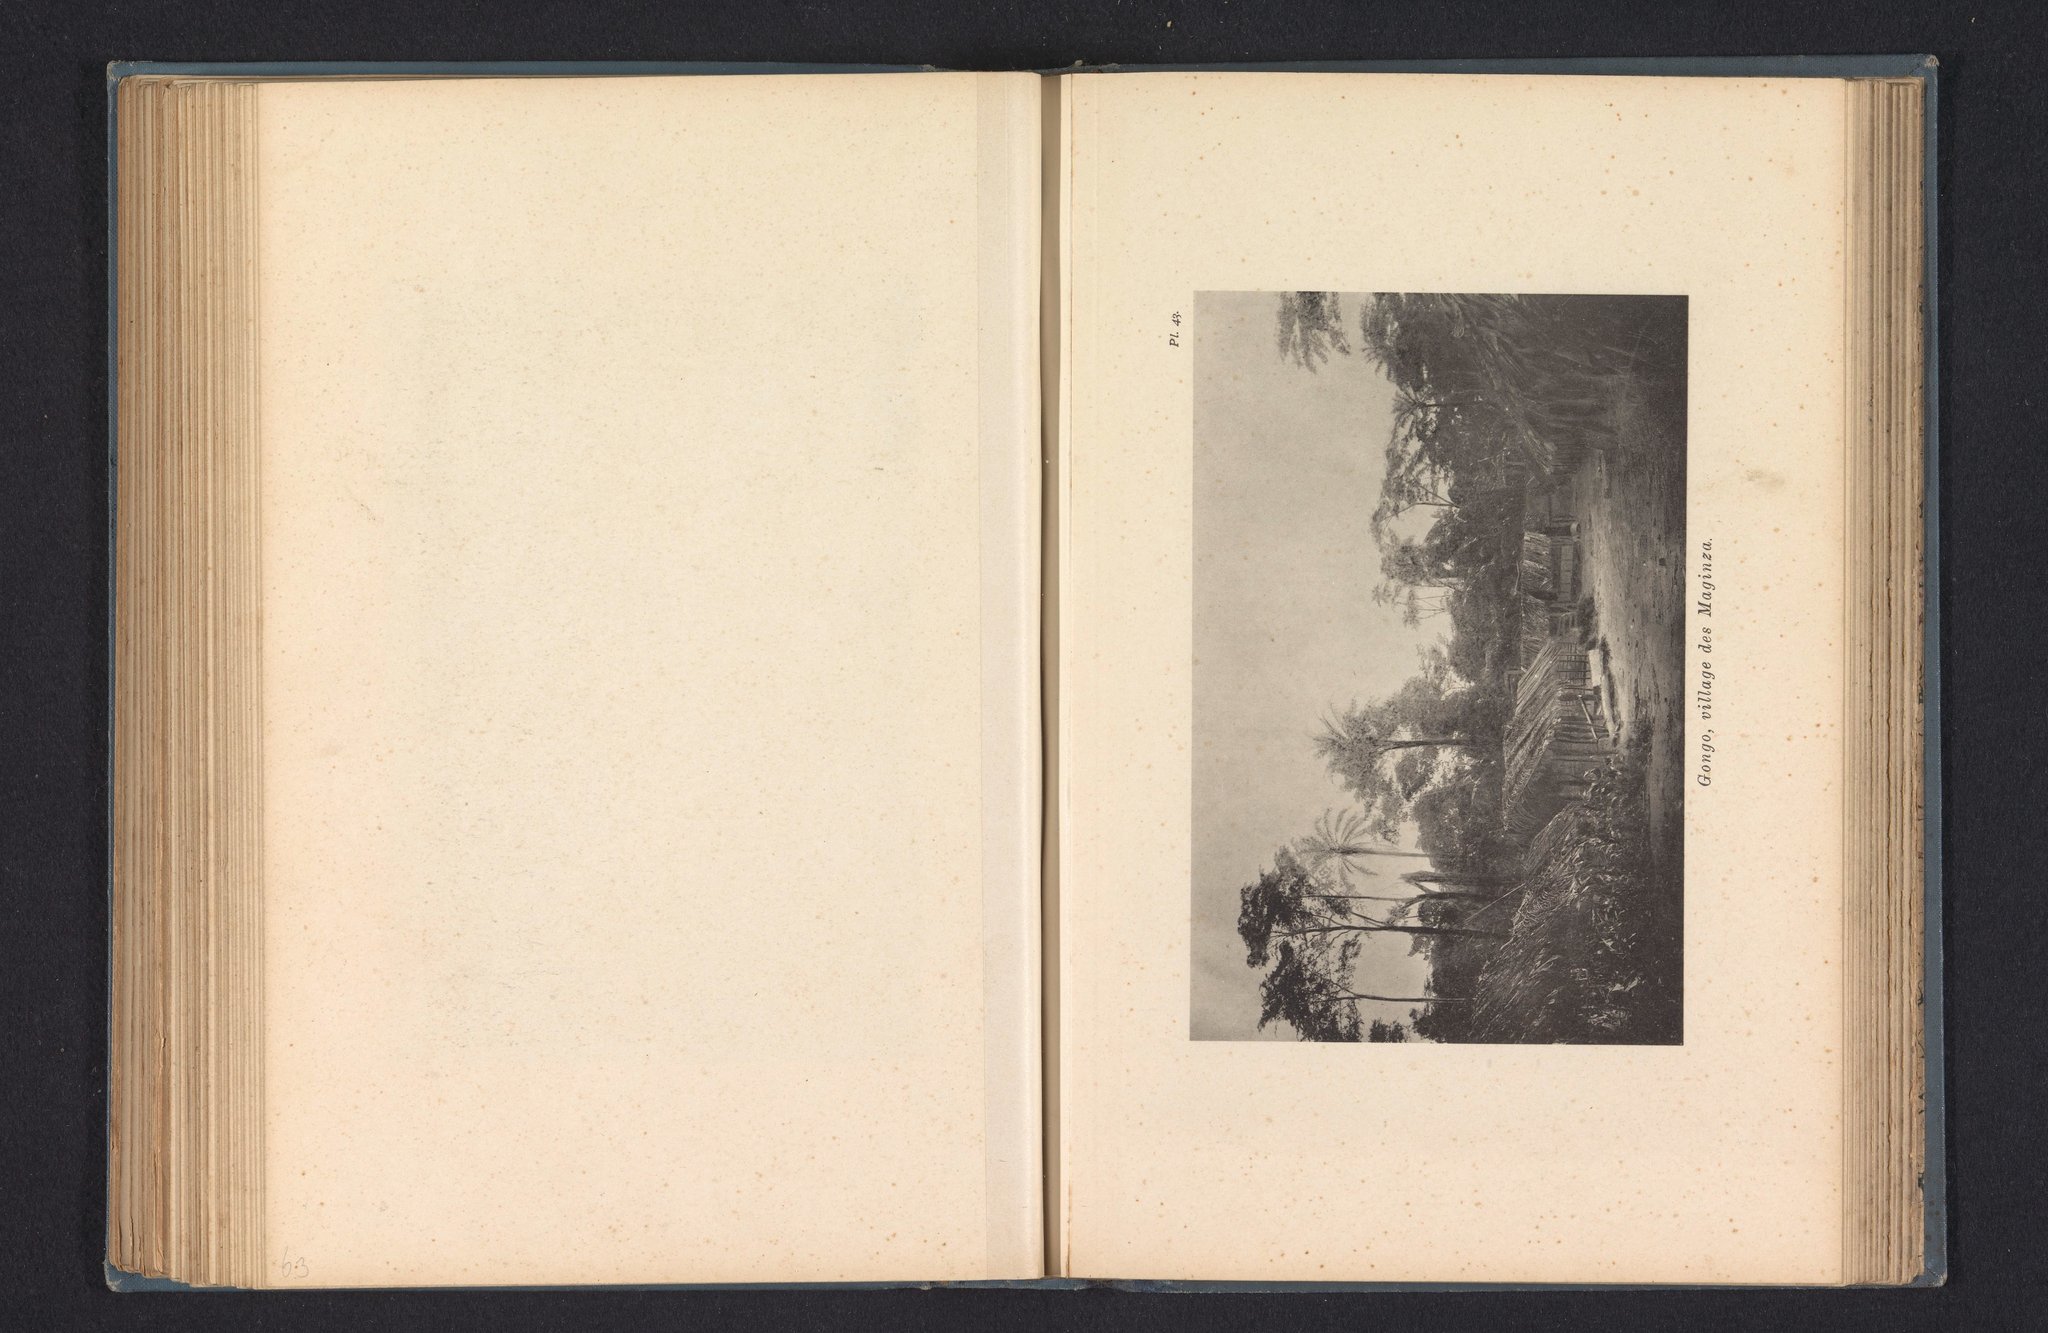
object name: photomechanical print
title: Woningen te Gongo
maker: franz thonner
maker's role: botanicus, ontdekkingsreiziger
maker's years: 1863-1928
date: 1896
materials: paper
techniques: photograph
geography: dresden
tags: housing, façade (of house or building)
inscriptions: number: ‘Pl. 43.’